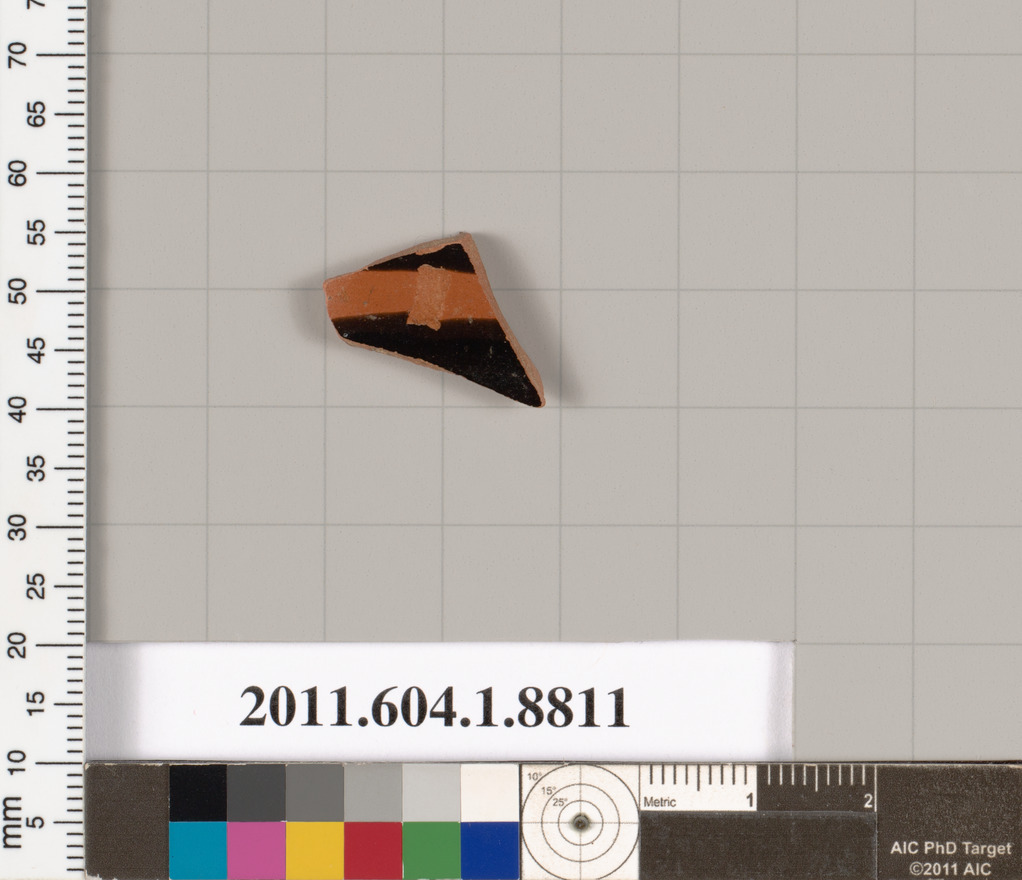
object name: kylix fragment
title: Terracotta fragment of a kylix (drinking cup)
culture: greek, attic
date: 600-401 BCE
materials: terracotta